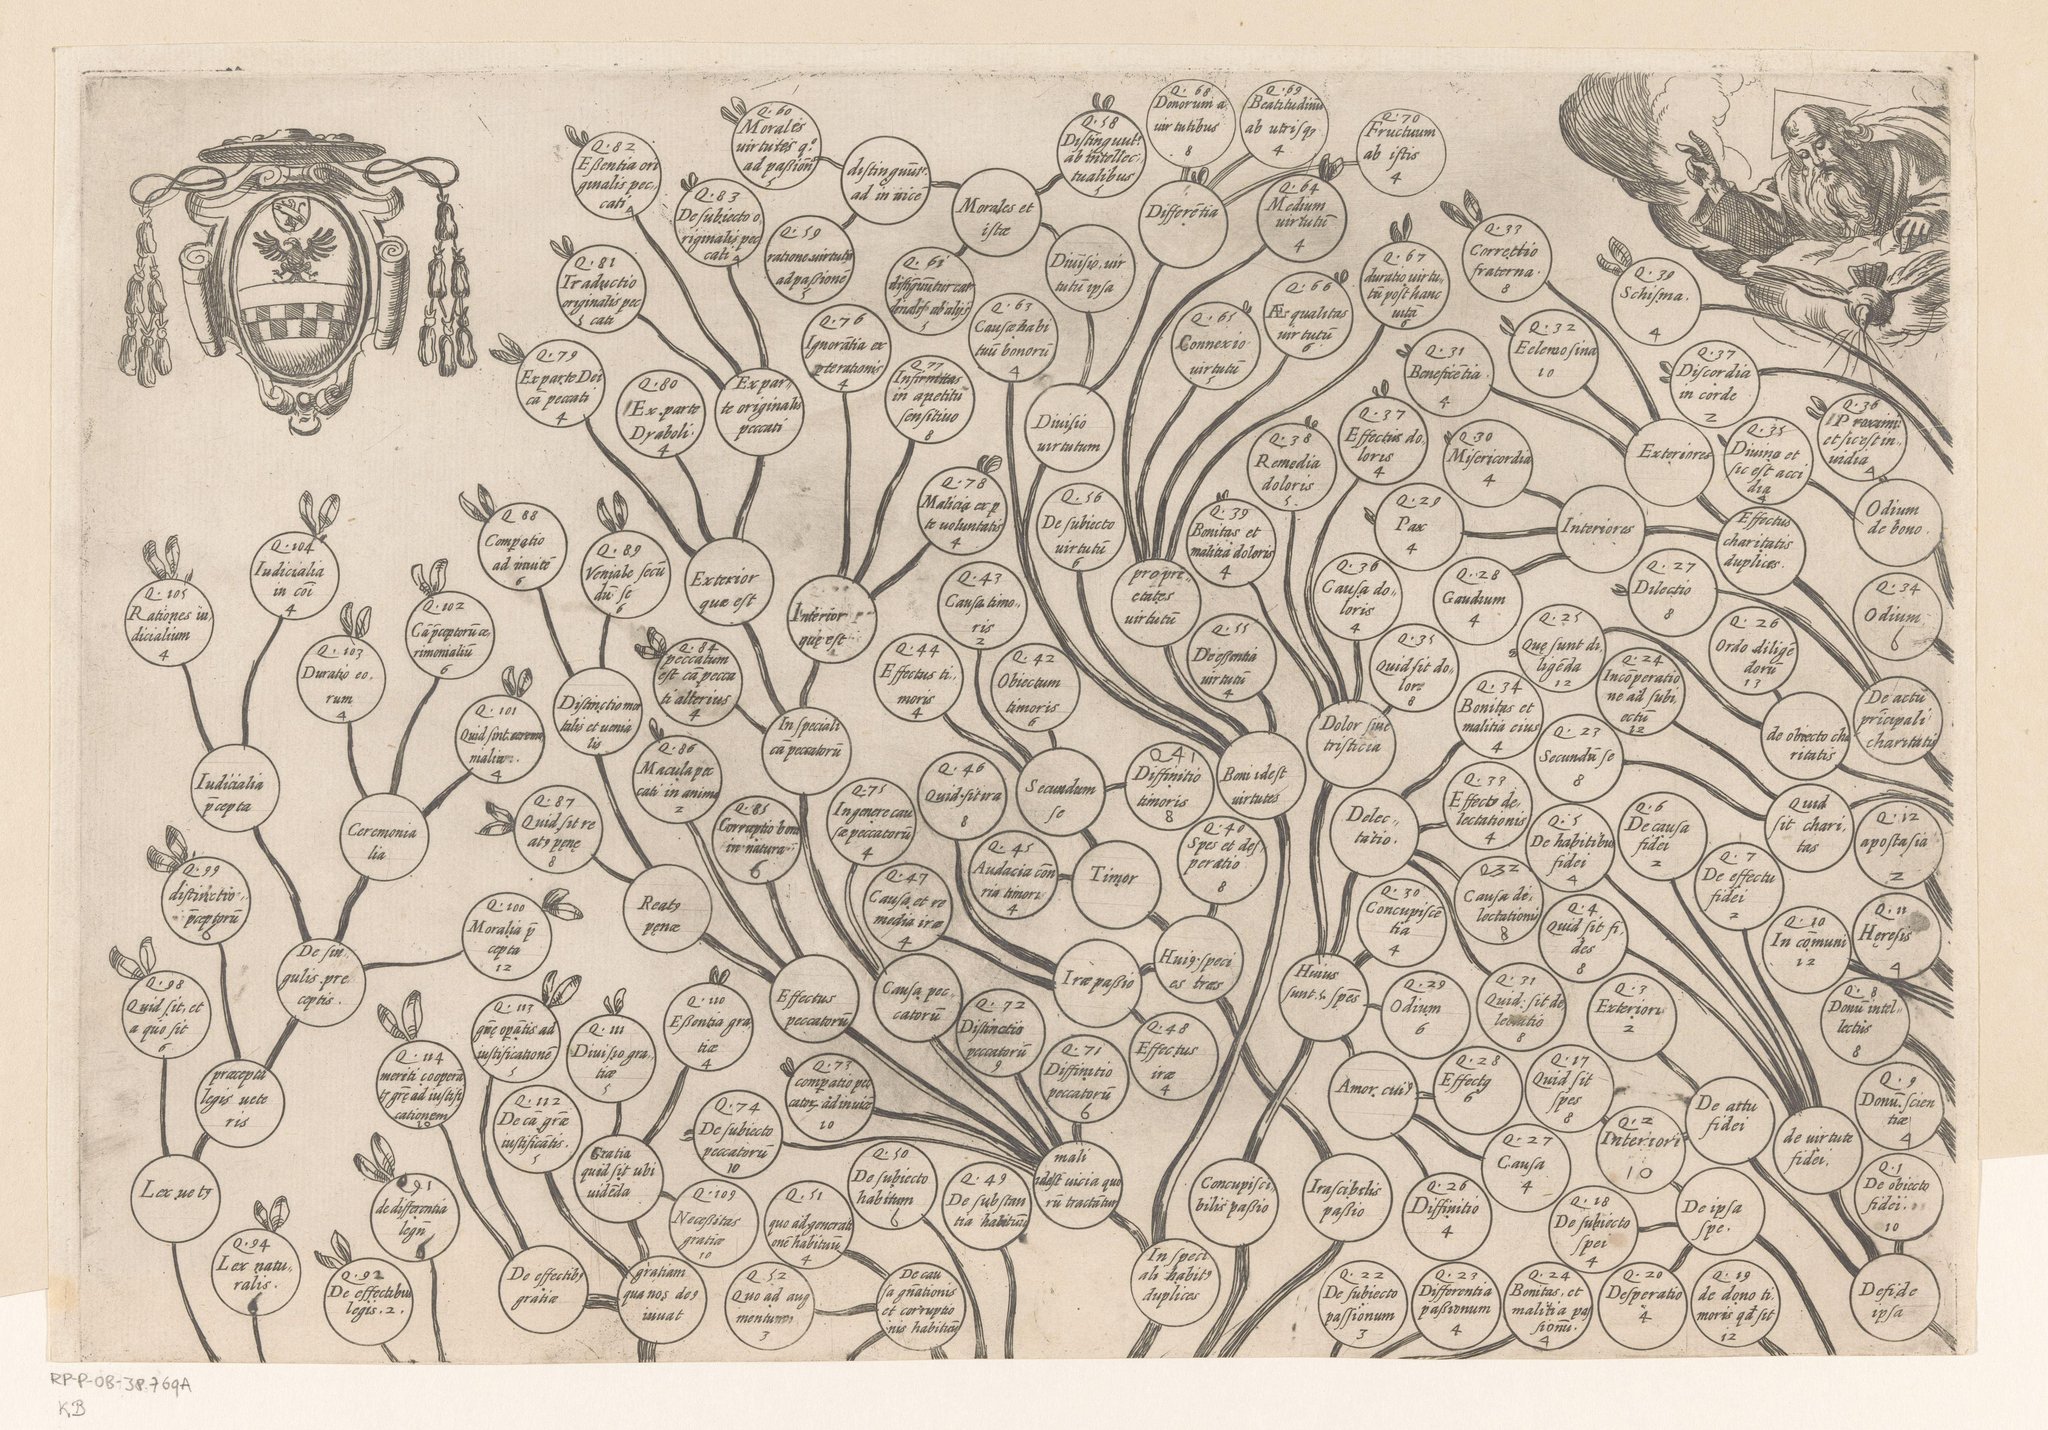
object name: print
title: Boom met Thomas van Aquino (deel linksboven)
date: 1590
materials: paper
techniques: etching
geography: italy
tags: thomas van aquino, christ crucified on a tree or on a vine, christian doctrine, the dominican theologian, 'angelic doctor' thomas of aquino; possible attributes: book, (chain with) sun, dove, girdle of chastity, lily, model of church, monstrance (or chalice), mitre (under feet), star (on breast)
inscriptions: collector's mark: Lugt 240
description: De filosoof en theoloog Thomas van Aquino ligt onderaan een boom. Op de stam van de boom de gekruisigde Christus. De vertakkingen van de boom representeren de drie delen van Aquino's 'Summa Theologiae'. Bovenaan in het midden God de Vader en de Heilige Geest als duif. Linksboven en rechtsboven een wapenschild.